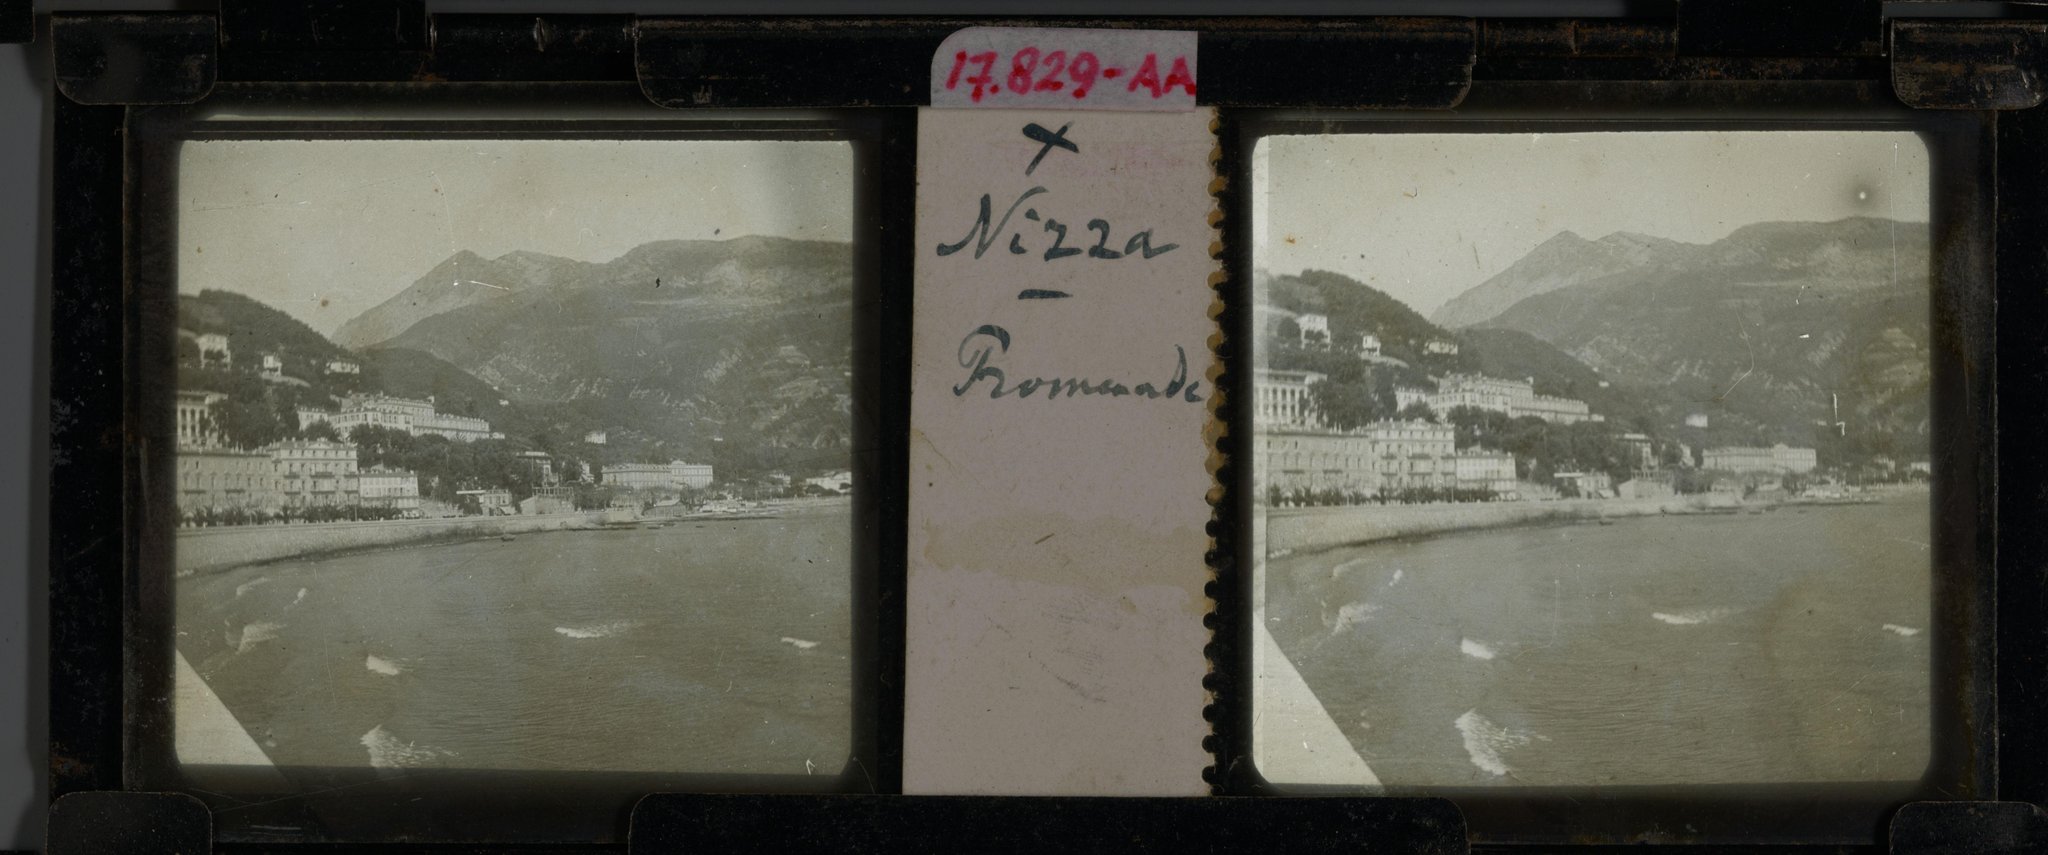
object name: album leaf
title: Nizza - Promenade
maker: Anonymous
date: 1920-1925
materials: glass, metal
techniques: slide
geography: nice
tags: gulf, bay, avenue, boulevard, promenade, esplanade